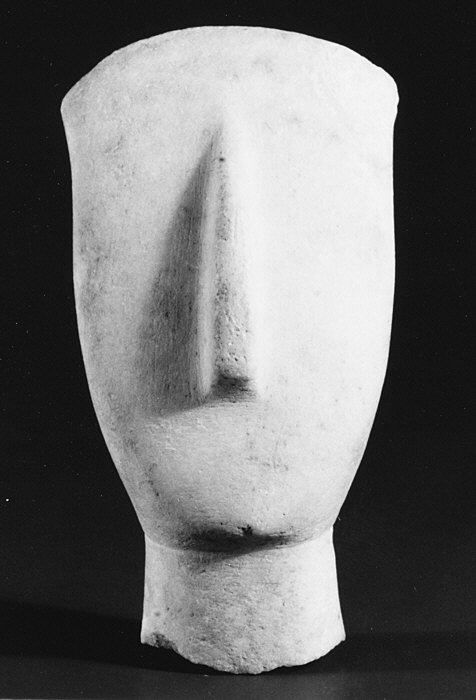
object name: head of a woman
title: Head and neck from a marble figure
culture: cycladic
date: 2700-2500 BCE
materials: marble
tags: human figures,heads